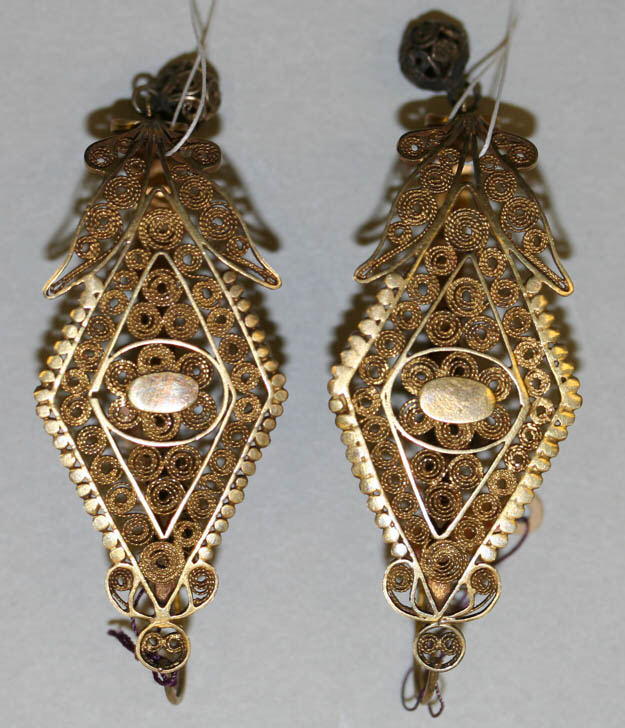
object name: earring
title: Earrings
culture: european, eastern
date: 1701-1900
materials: metal